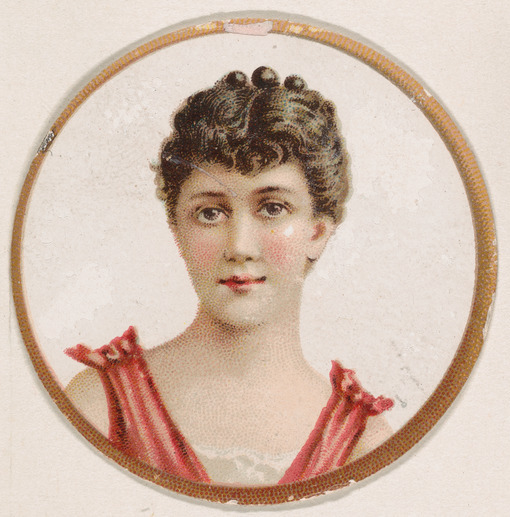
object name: print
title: Portrait of woman, from the Novelties series (N228, Type 2) issued by Kinney Bros.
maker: kinney brothers tobacco company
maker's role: publisher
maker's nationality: american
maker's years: 1869-2011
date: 1889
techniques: color lithograph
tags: portraits,women